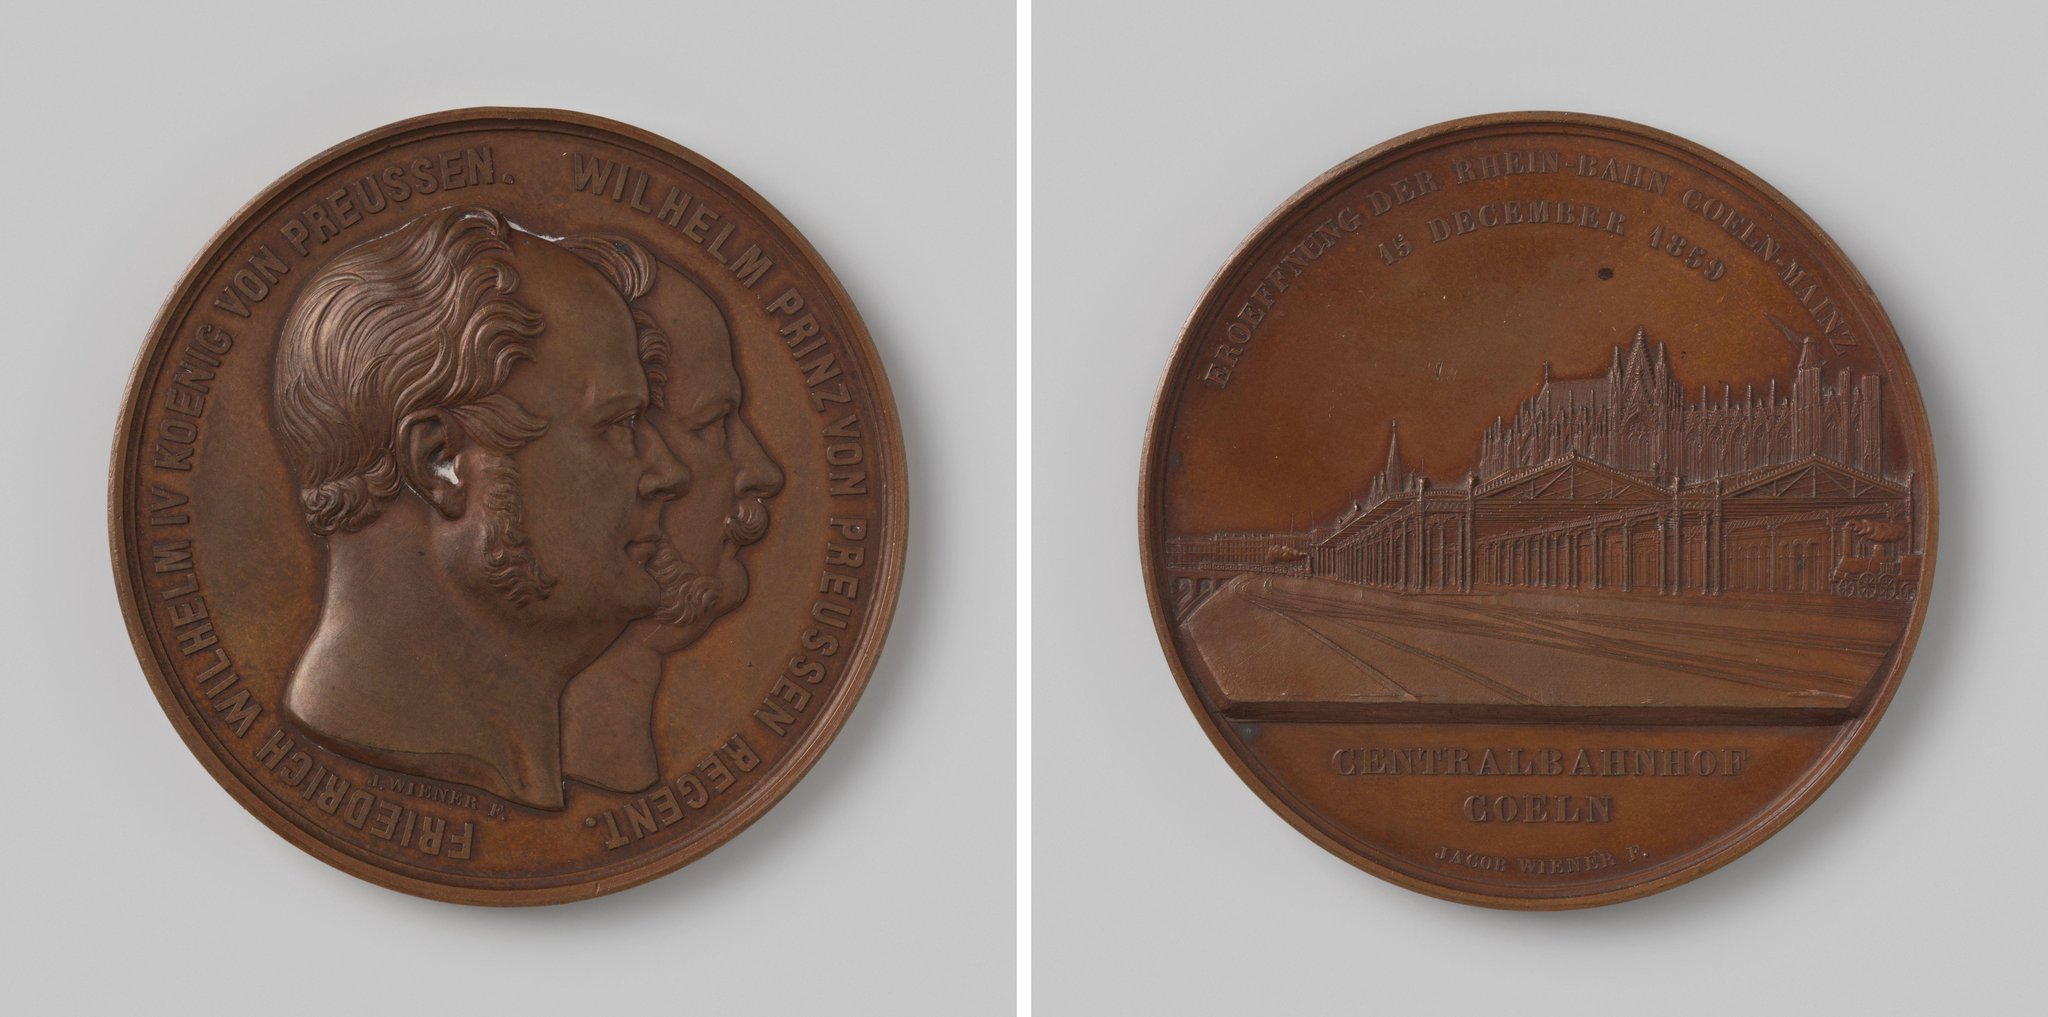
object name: history medal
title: Opening van de spoorweg Keulen - Mainz 1859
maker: jacob wiener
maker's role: medailleur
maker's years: 1815-1899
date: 1859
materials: bronze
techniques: striking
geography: brussels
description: Bronzen penning, op de voorzijde de geconjugeerde portretten van Koning Frederik Willem en Prins-Regent Willem naar rechts met omschrift, op de keerzijde het aanzicht van het centrale station te Keulen met dubbel omschrift en afsnedetekst.